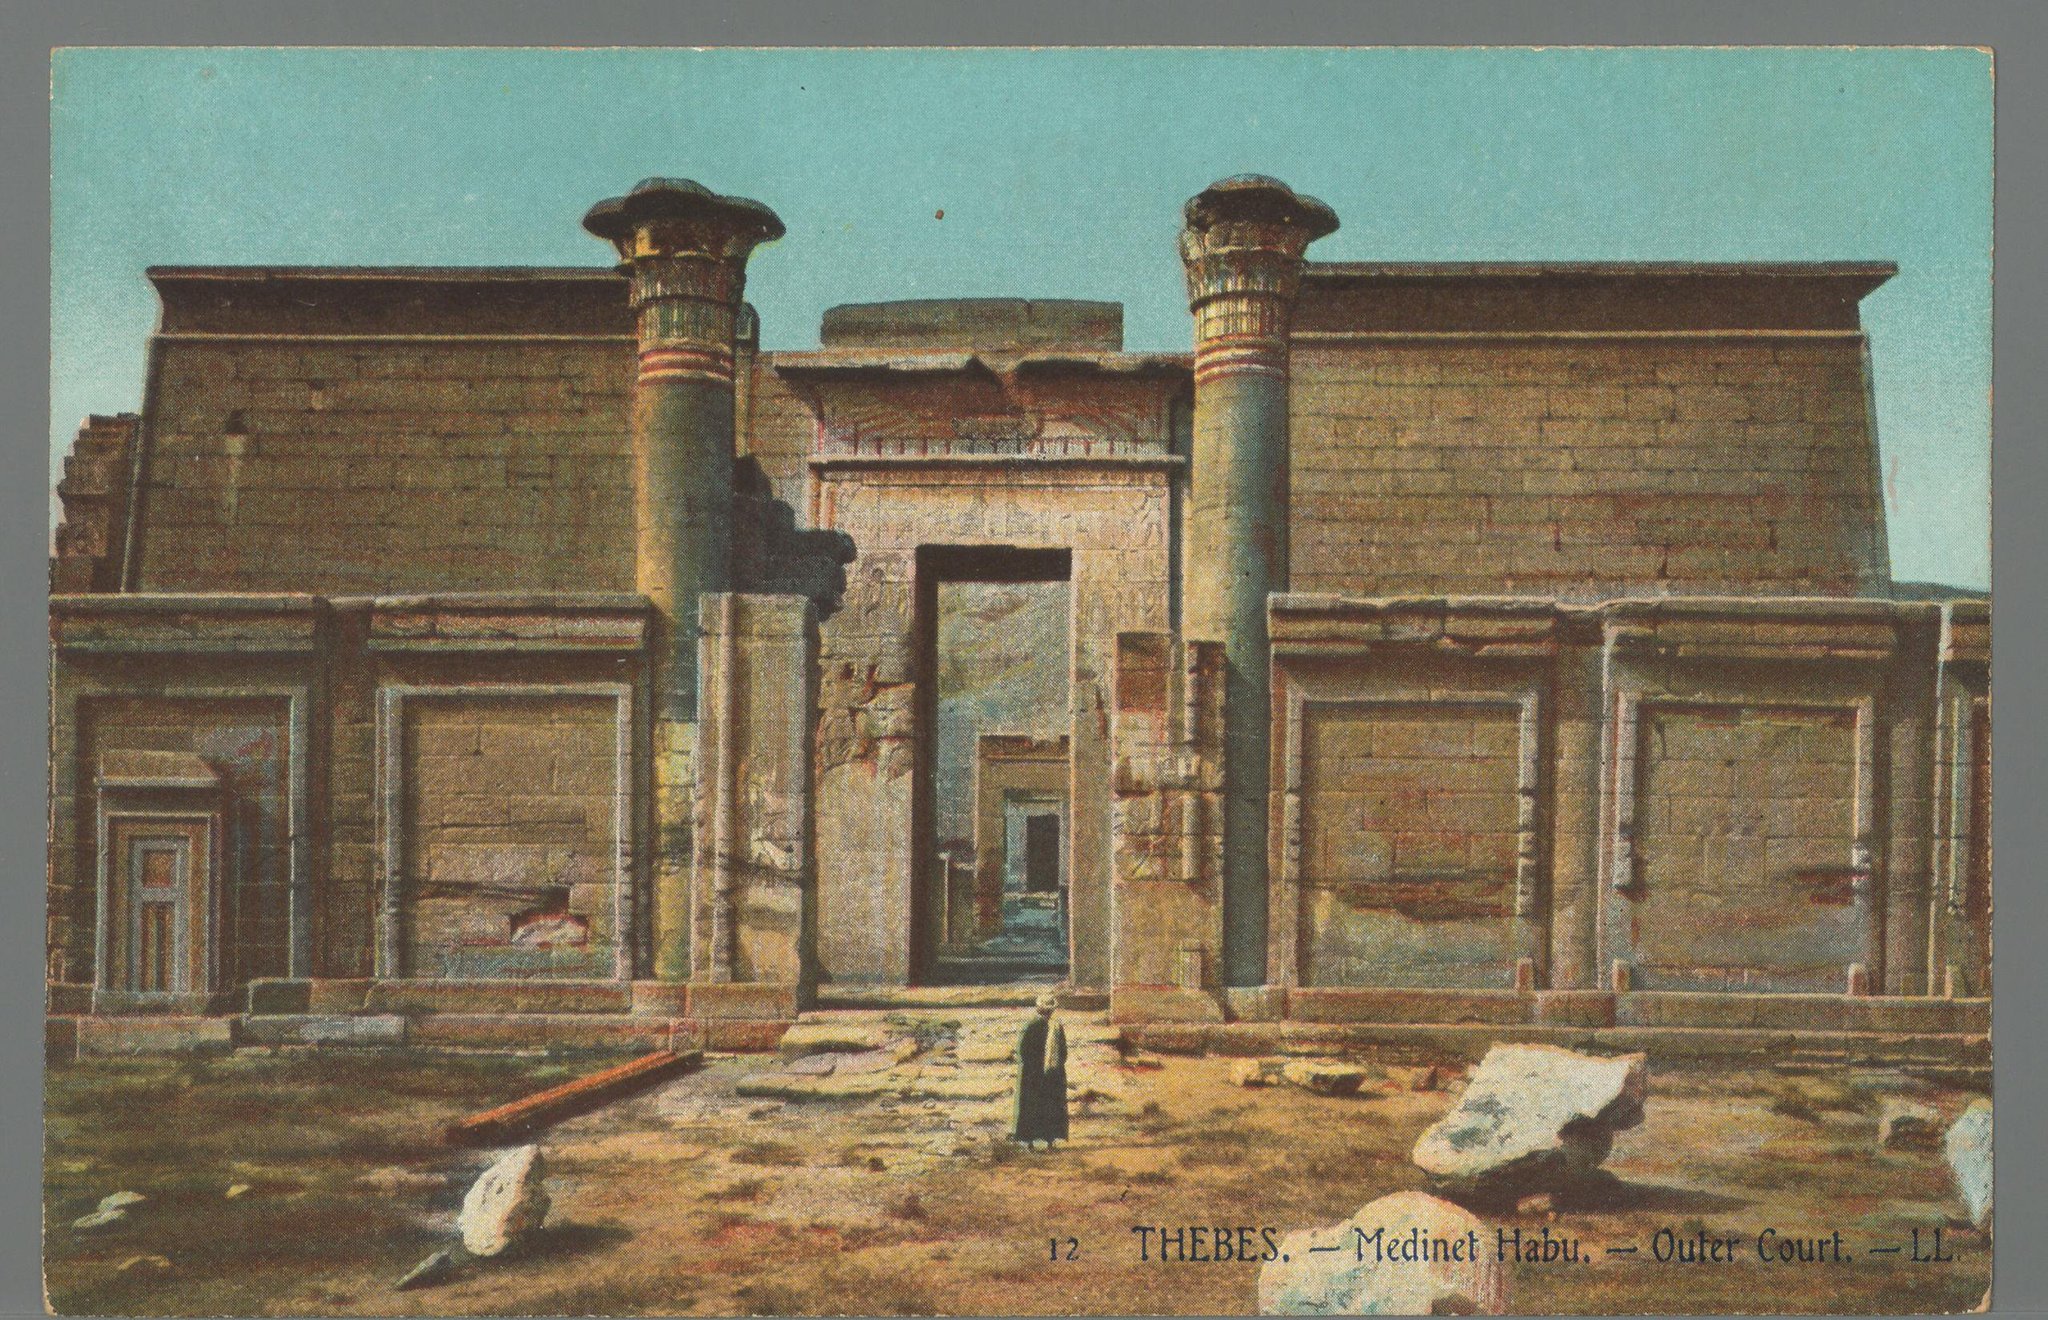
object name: ansichtkaart, prentbriefkaart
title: Thebes - Medinet Habu - Outer Court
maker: Anonymous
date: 1907-1930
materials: cardboard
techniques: lithograph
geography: paris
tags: temple, shrine ~ egyptian religion